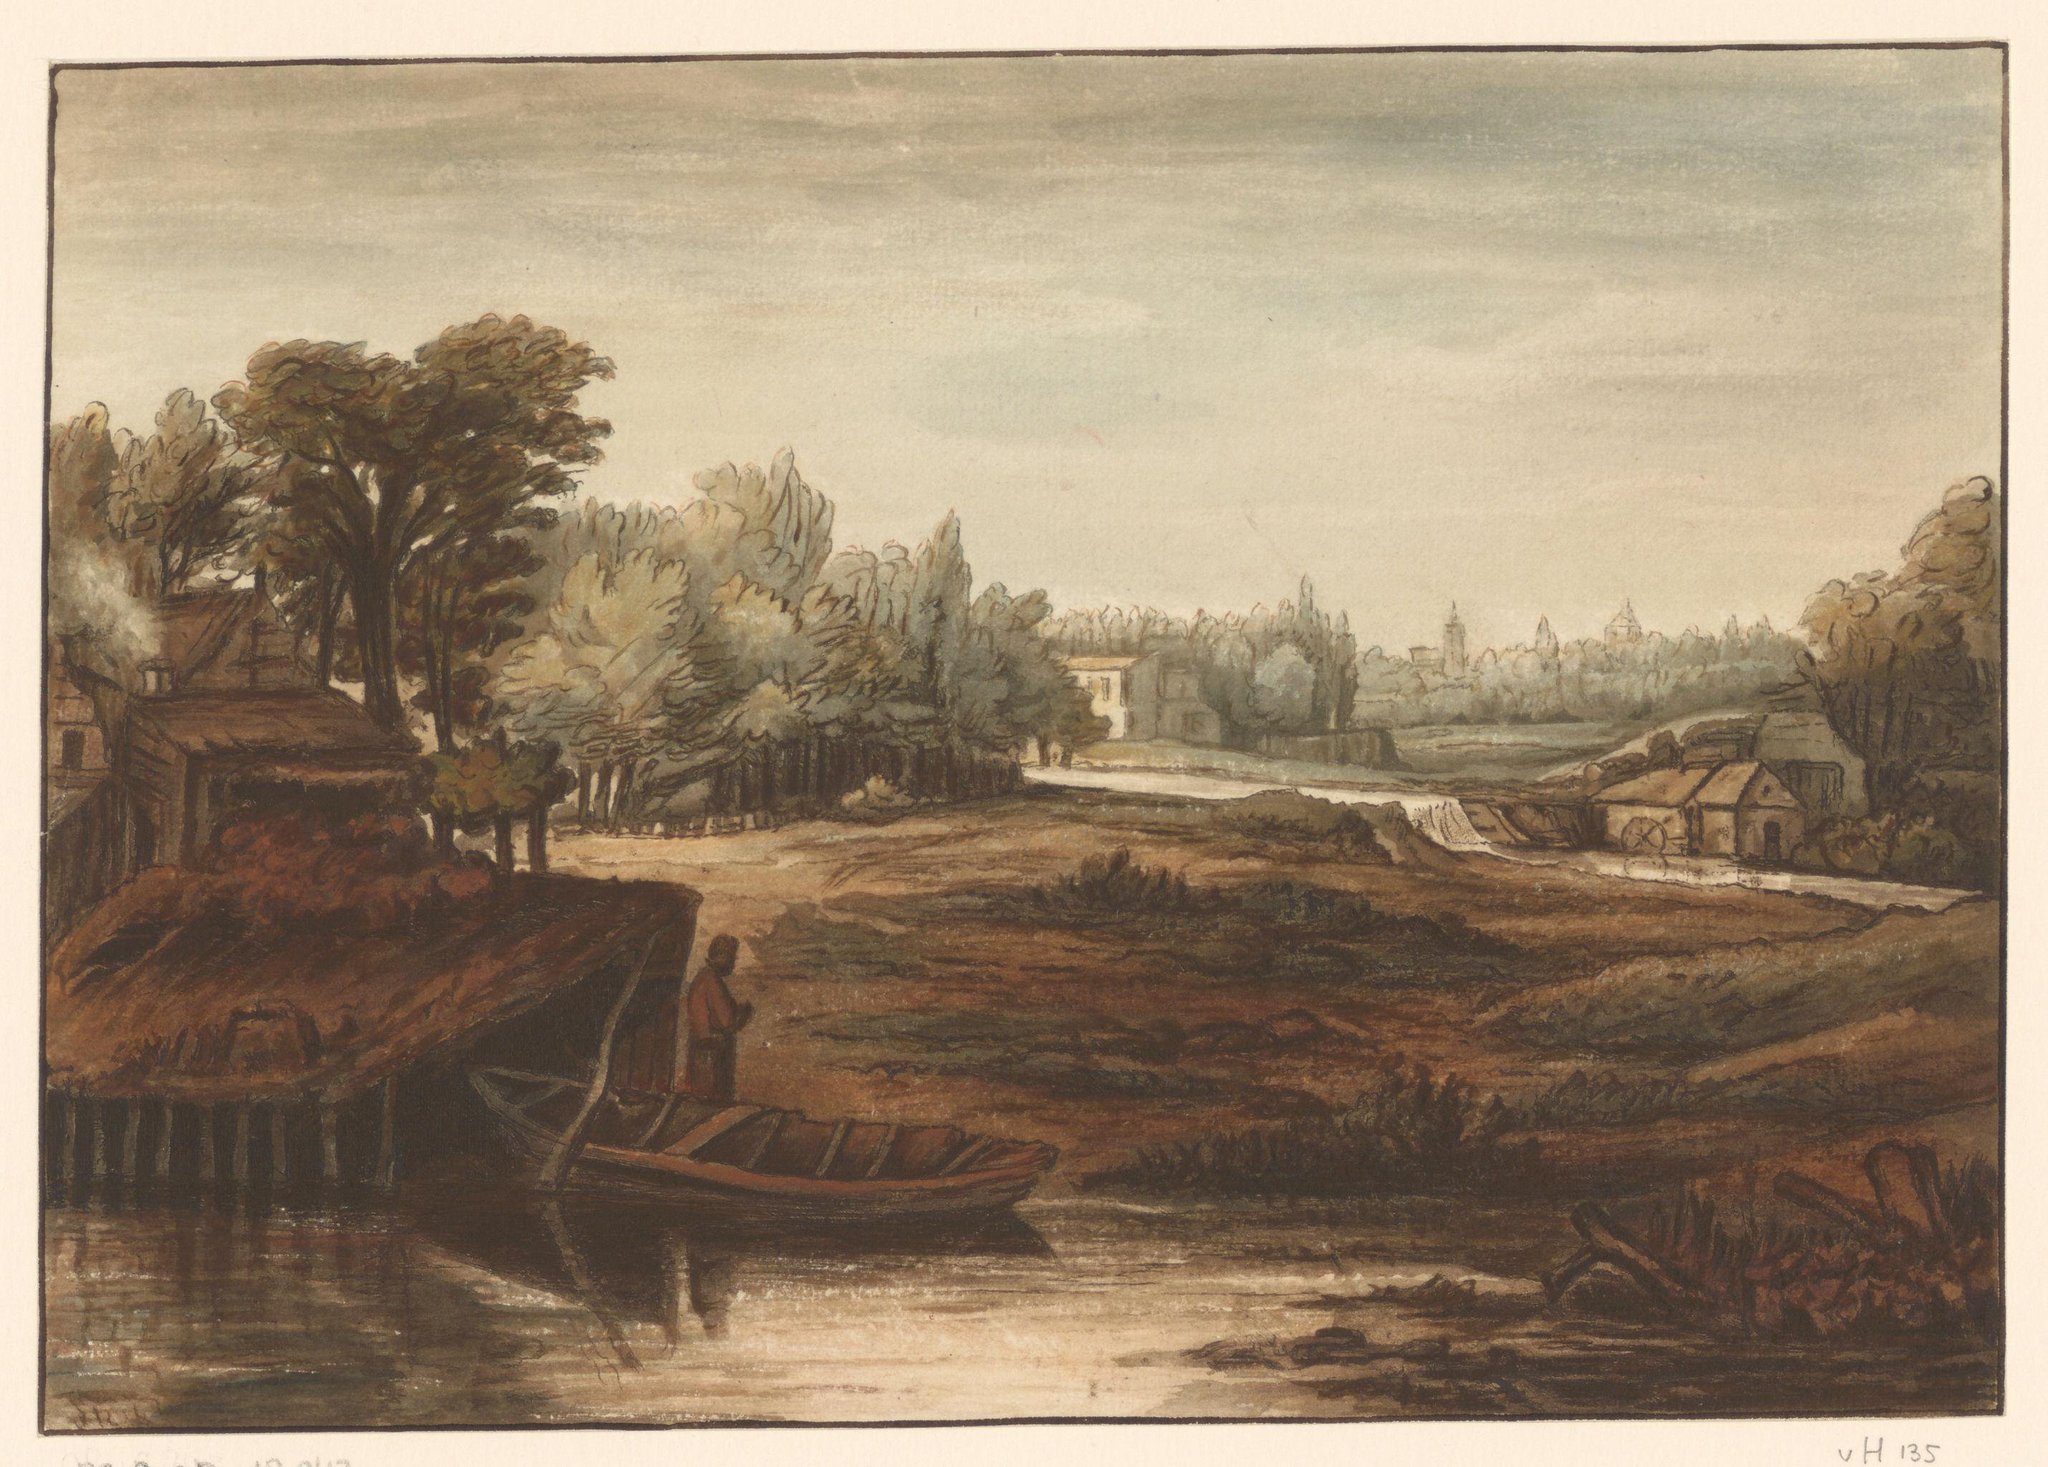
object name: print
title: Landschap met watermolen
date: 1818-1828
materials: paper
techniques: hand coloring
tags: watermill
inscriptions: collector's mark: Lugt 12